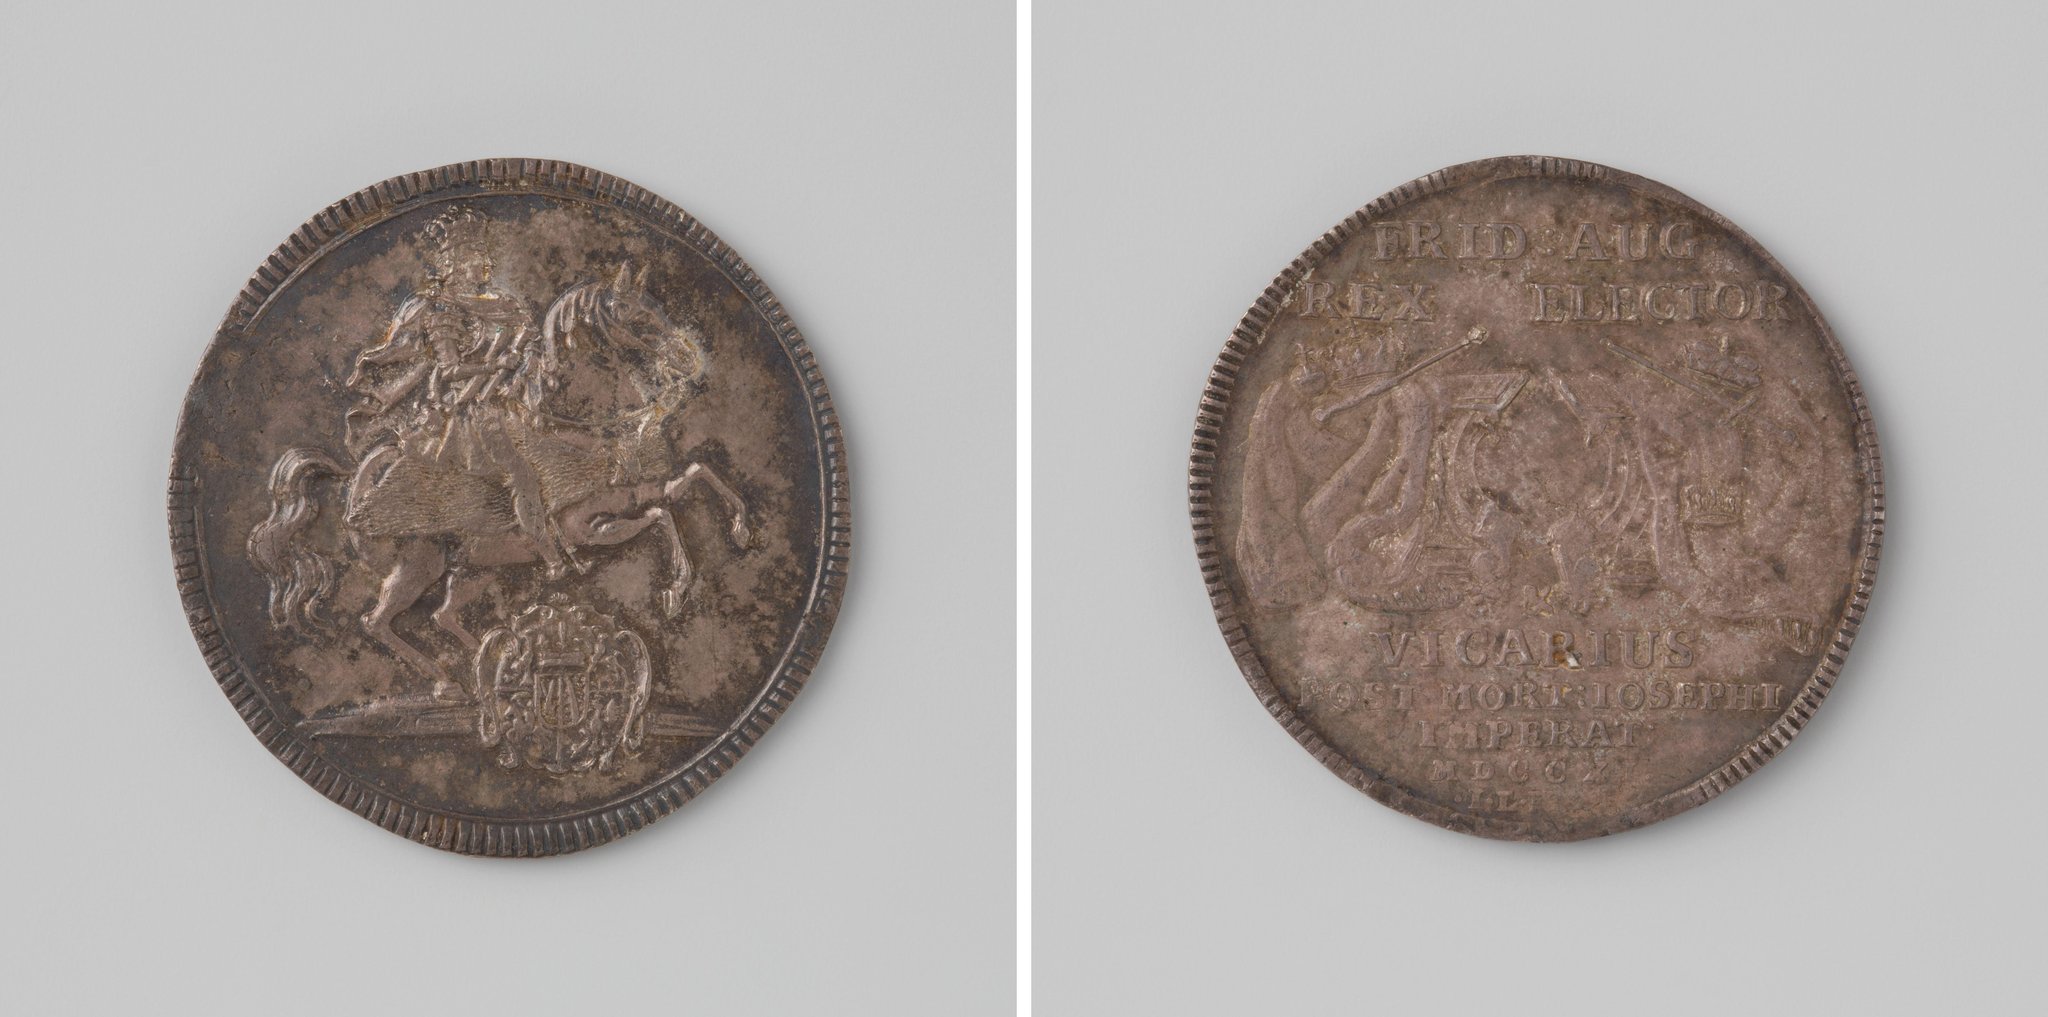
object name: history medal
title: Frederik Augustus, koning van Polen en keurvorst van Saksen aangesteld tot stadhouder van het Roomse Rijk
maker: johann lorenz holland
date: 1711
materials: silver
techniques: striking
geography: dresden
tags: august ii (king of poland)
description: Zilveren penning. Voorzijde: portret ruiter met kroon en commandostaf boven wapenschild. Keerzijde: op linker tafel ligt keizerskroon, scepter en rijksappel, op rechter keurvorstelijke muts en degen tussen opschriften